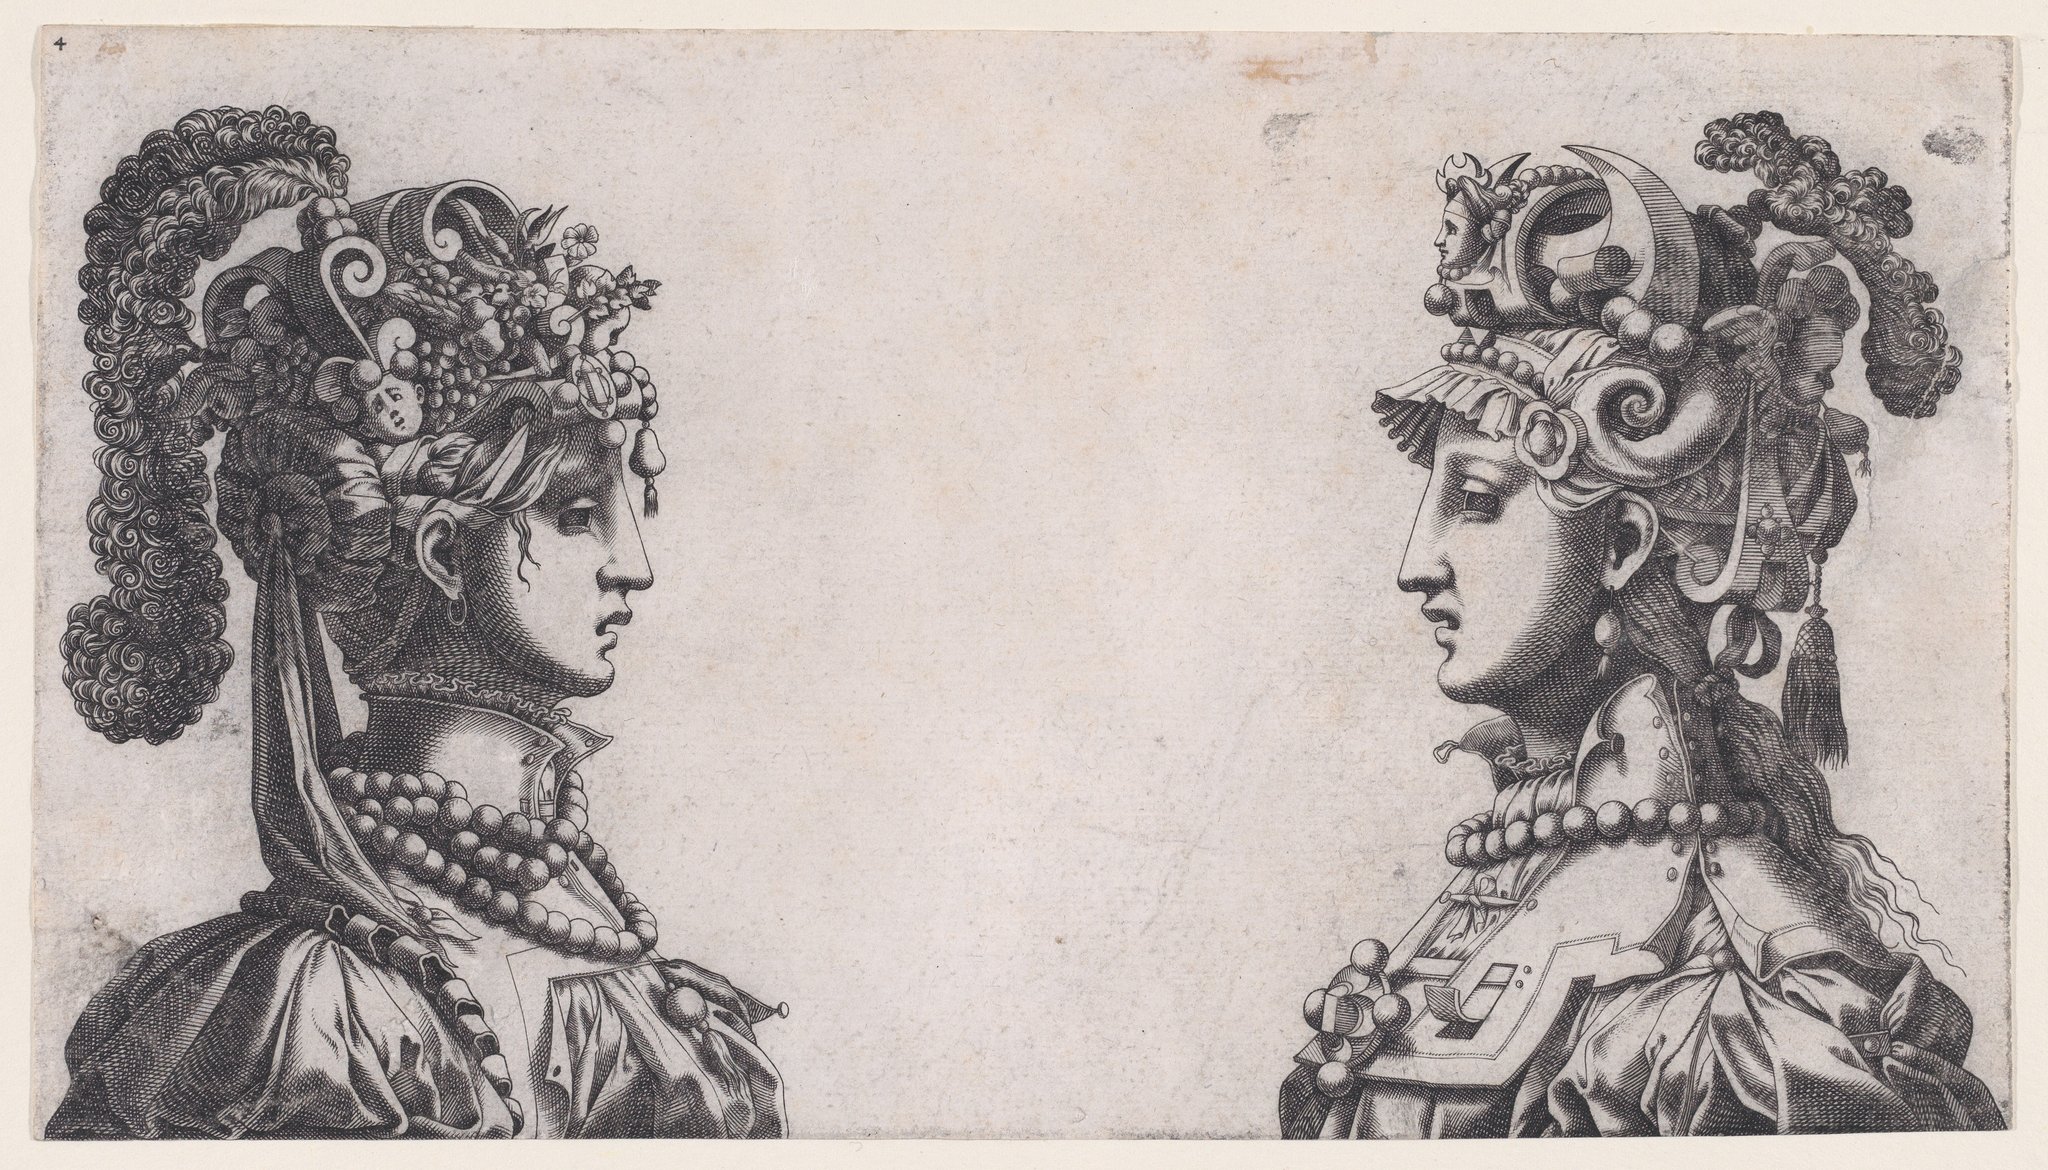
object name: print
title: Busts of Two Women Wearing Fantastical Head-dresses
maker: rené boyvin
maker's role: artist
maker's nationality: french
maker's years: 1525-1598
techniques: engraving